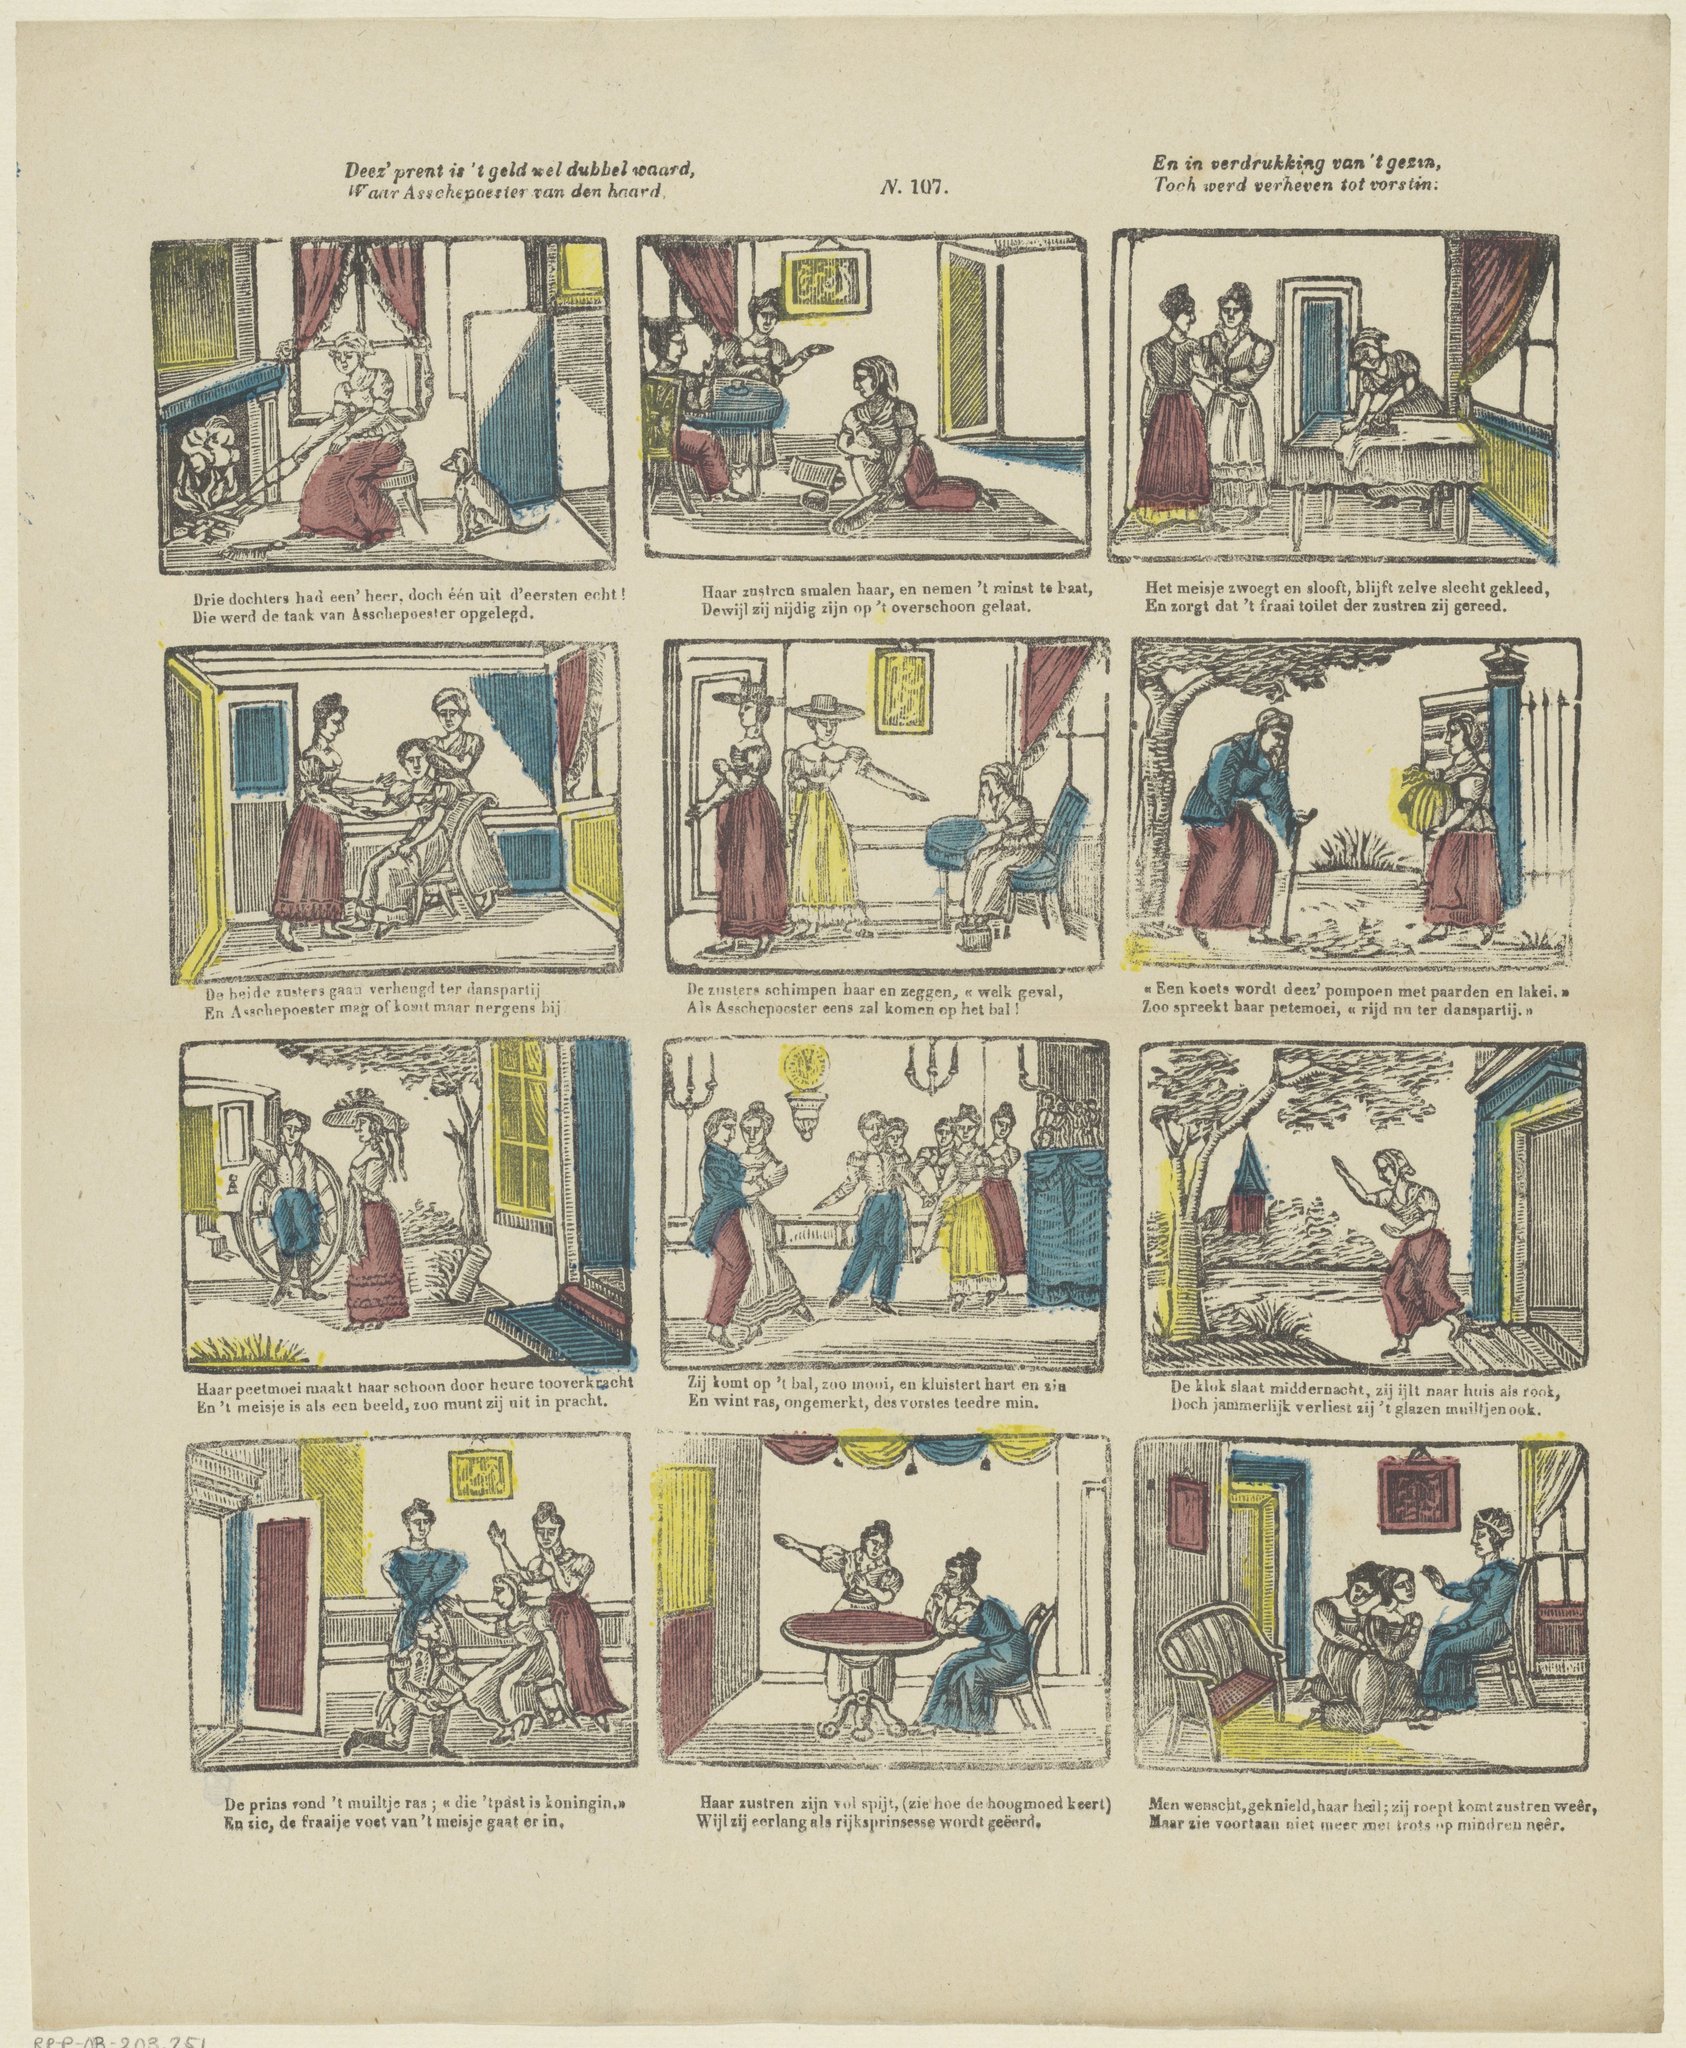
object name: popular print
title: Deez' prent is 't geld wel dubbel waard, / Waar Asschepoester van den haard / En in verdrukking van 't gezin, / Toch werd verheven tot vorstin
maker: Anonymous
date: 1856-1900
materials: paper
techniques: colour, letterpress printing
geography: turnhout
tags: tales and fairy tales (with title)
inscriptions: collector's mark: Lugt 2760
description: Blad met 12 voorstellingen uit het prookje van Assepoester. Onder elke afbeelding een tweeregelig vers. Genummerd midden boven: N. 107.